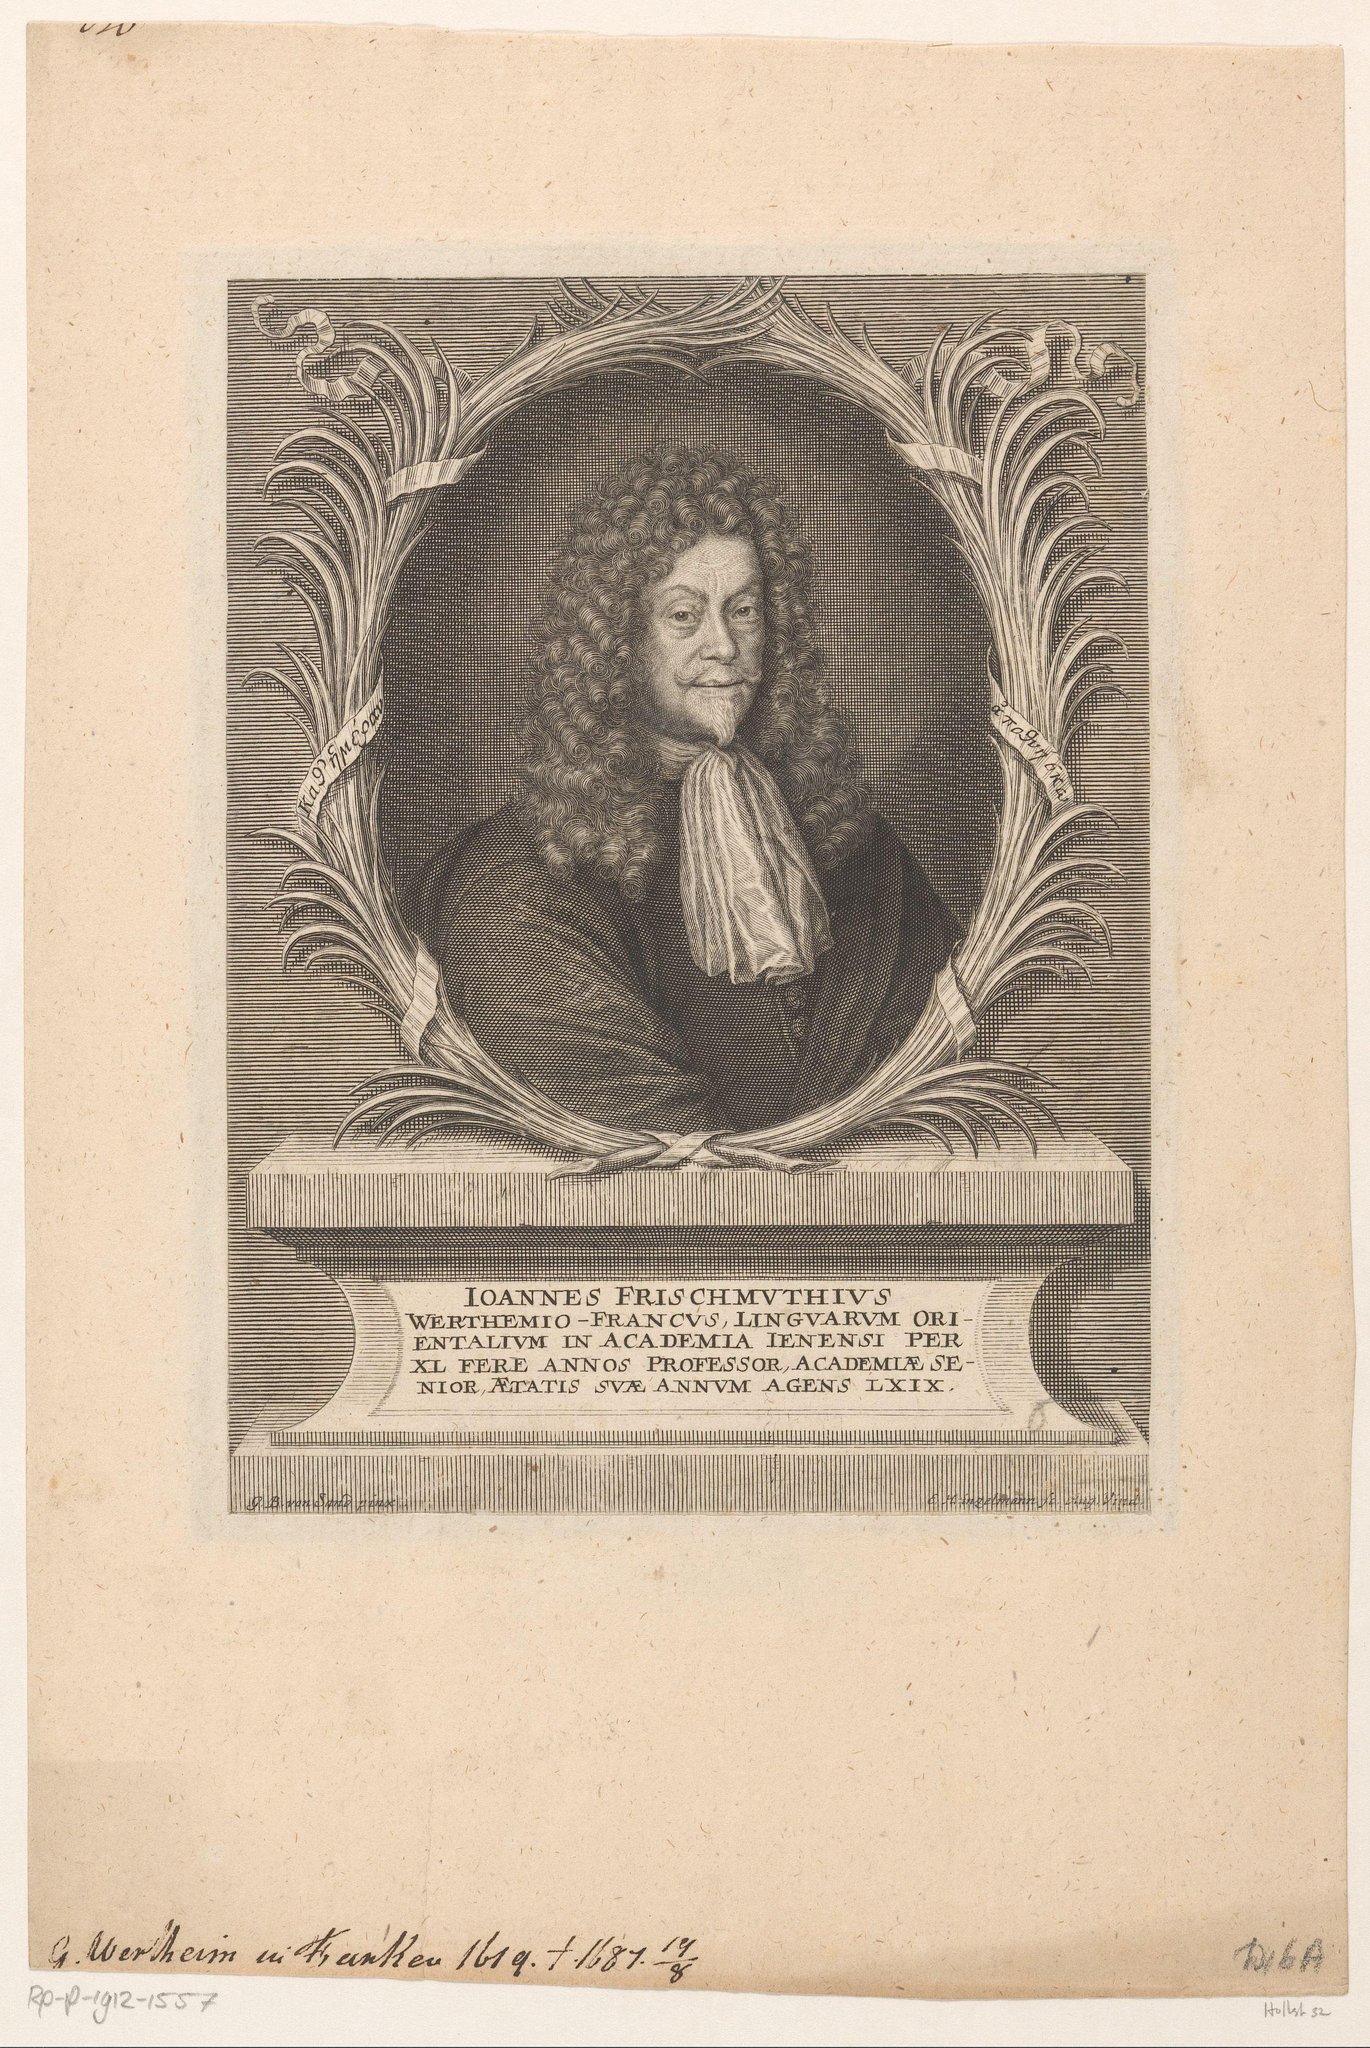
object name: print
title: Portret van Johann Frischmuth op 69-jarige leeftijd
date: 1688-1689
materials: paper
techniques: engraving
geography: augsburg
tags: trees: palm-tree (+ branch, stick), historical persons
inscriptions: collector's mark: Lugt 2228